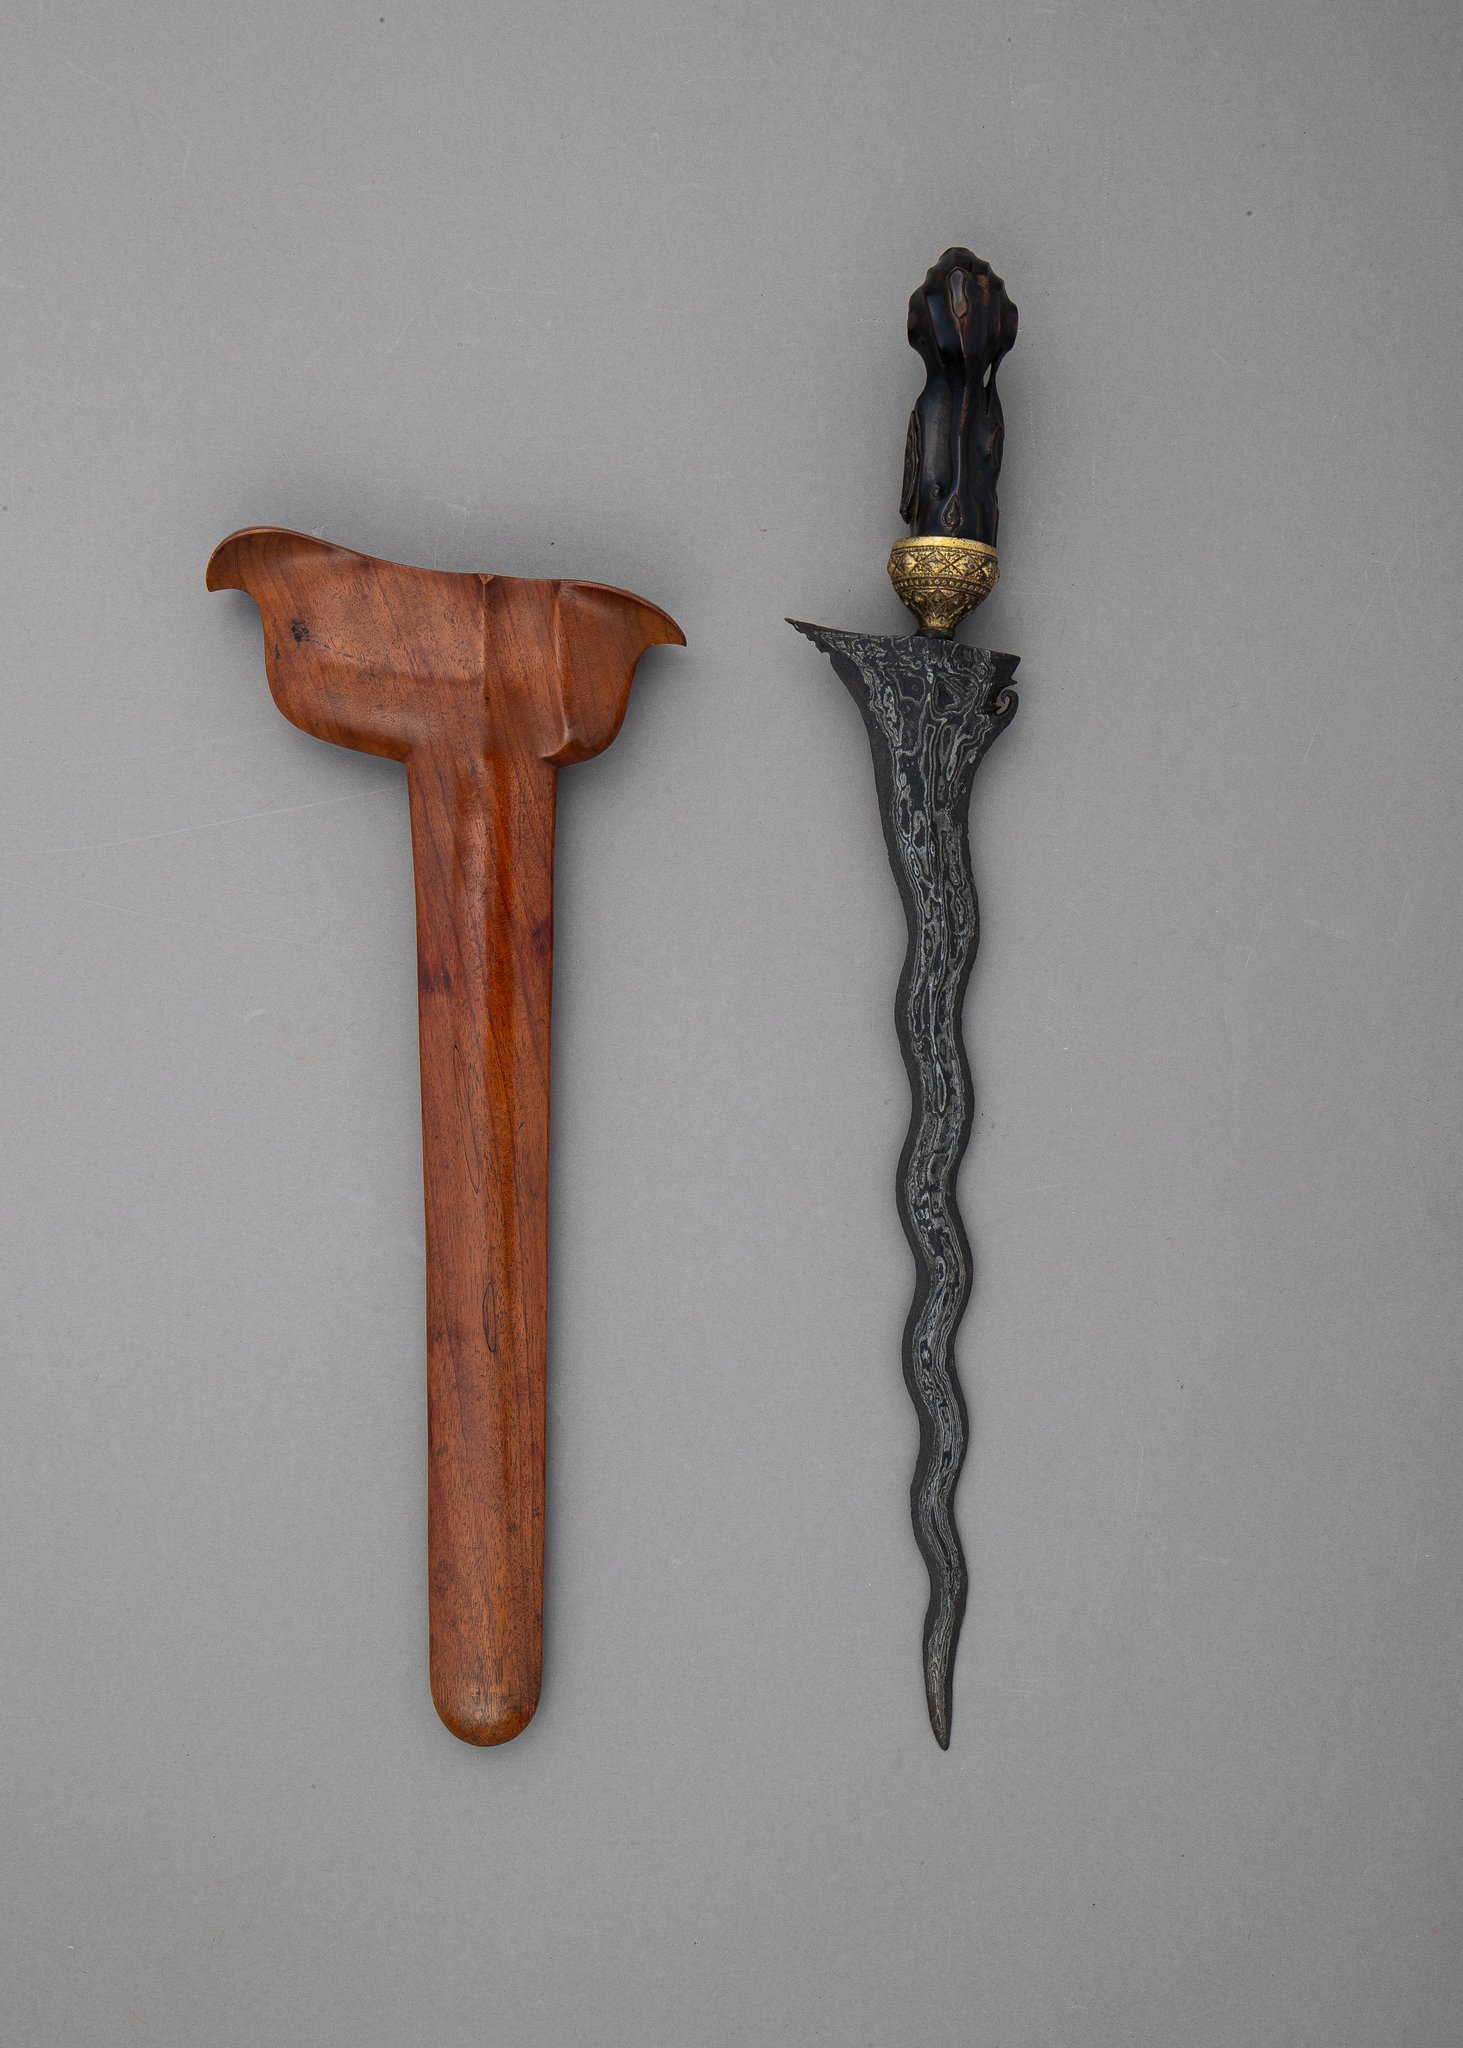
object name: kris with sheath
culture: javanese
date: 1501-1900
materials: brass, steel, wood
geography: indonesia